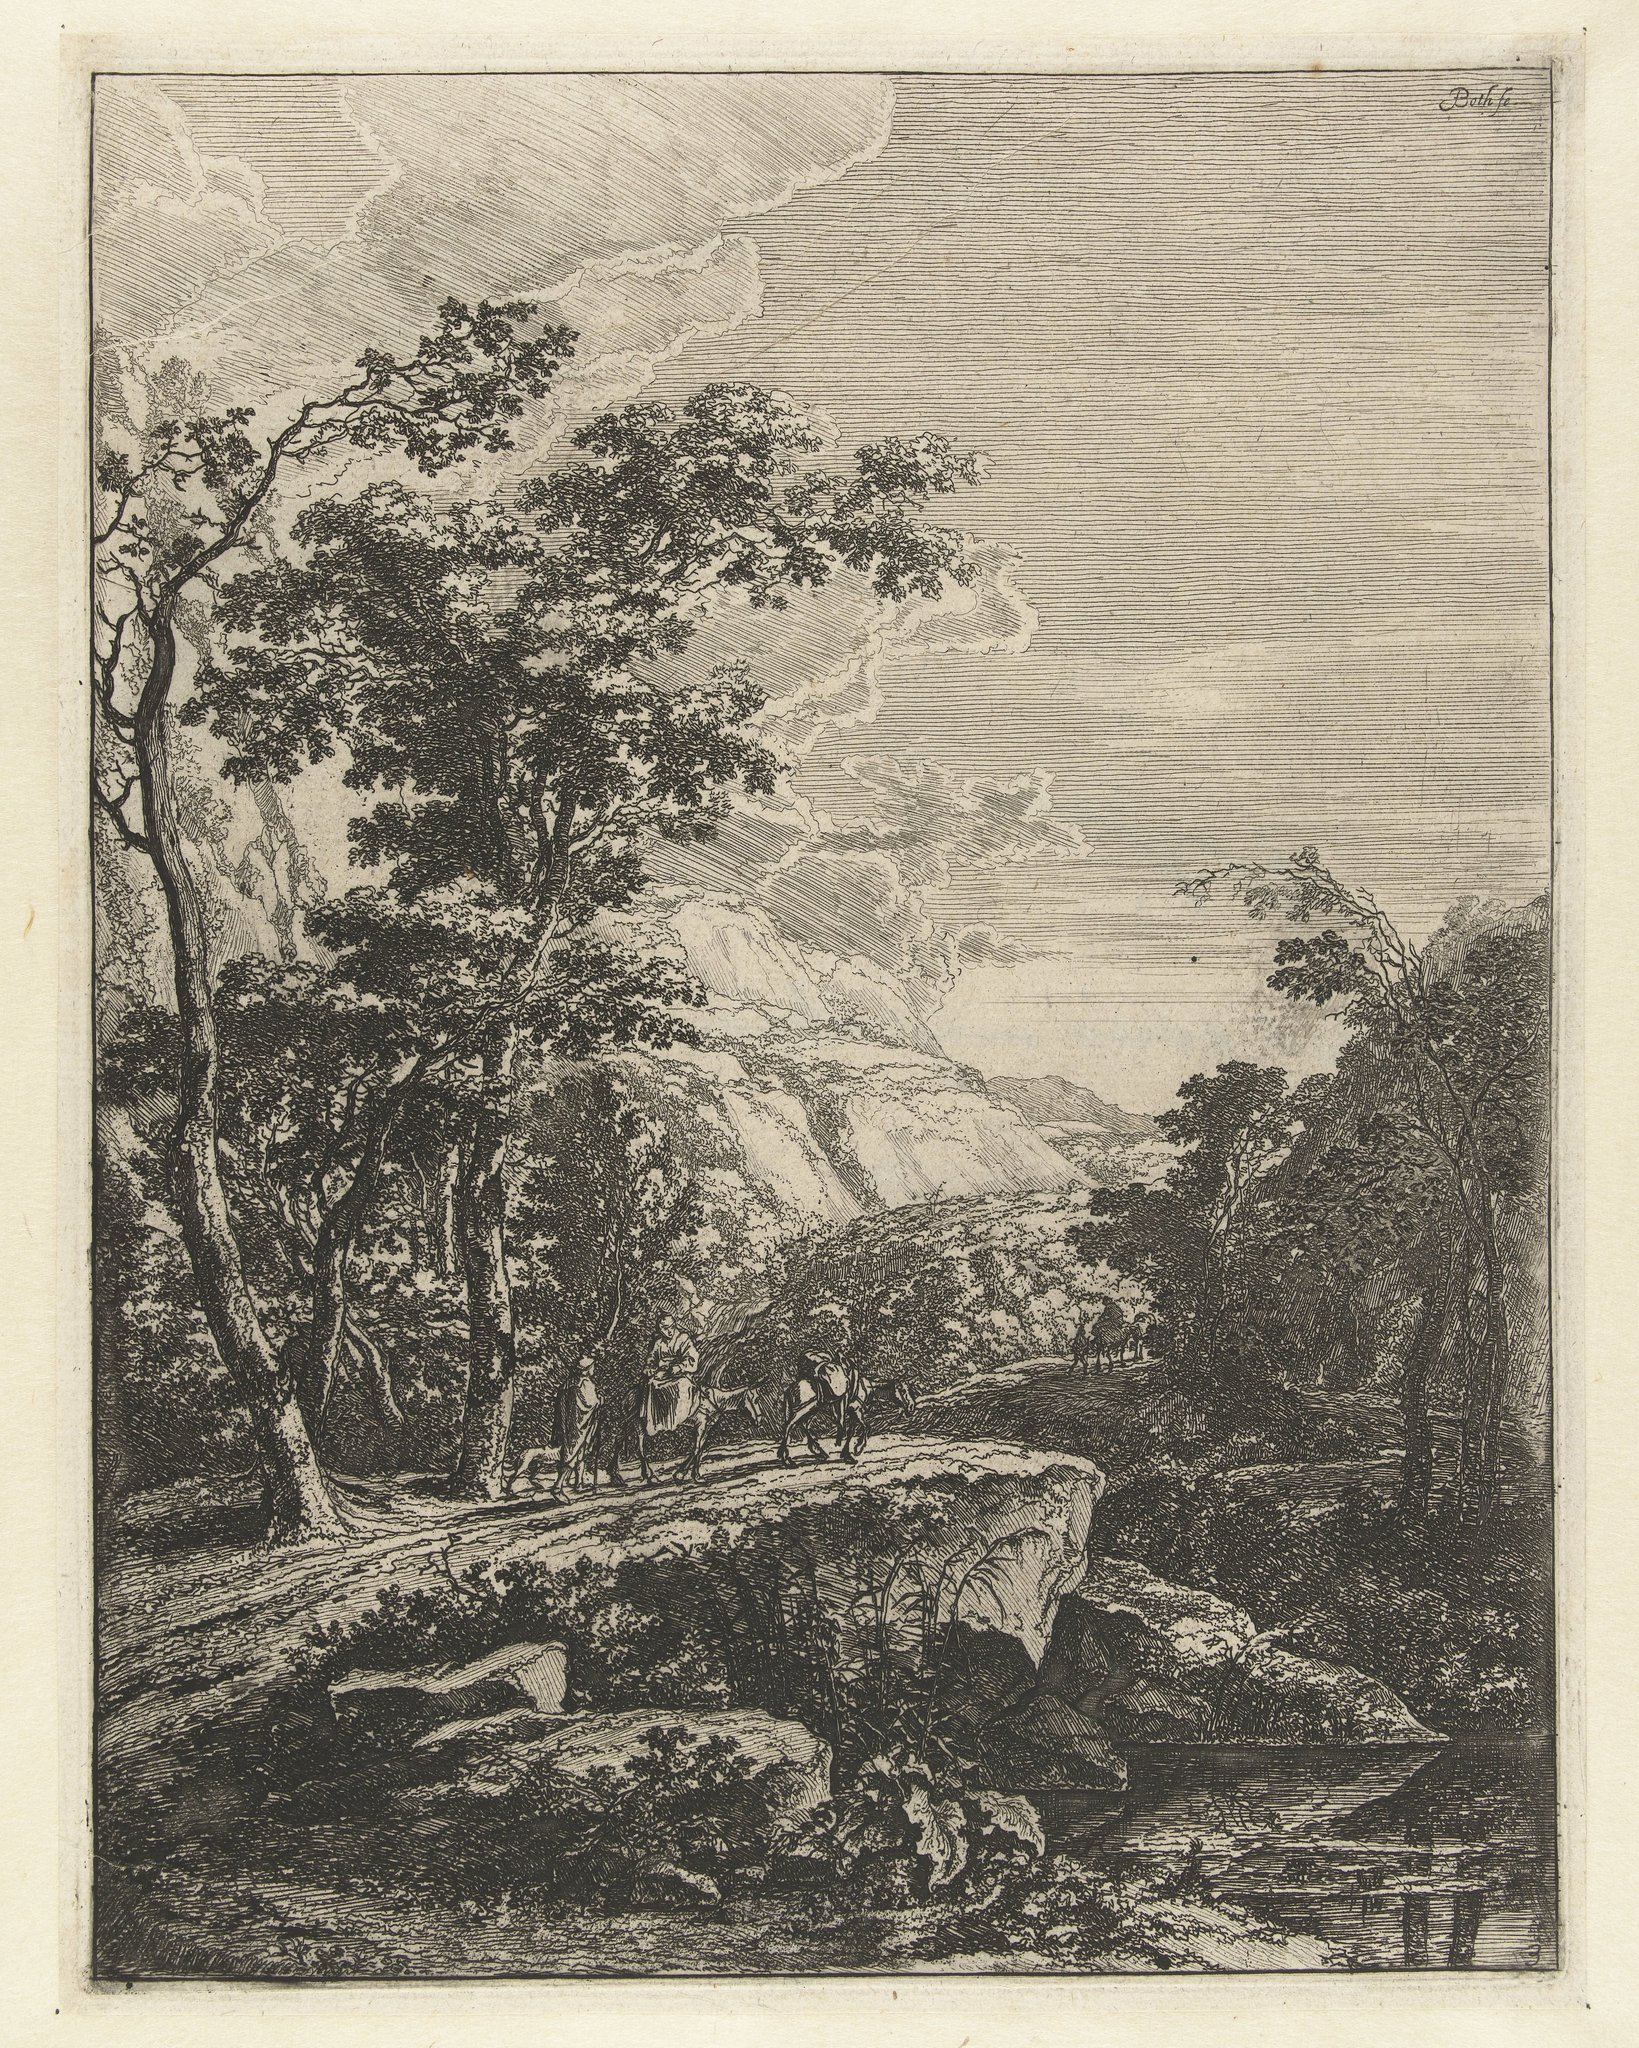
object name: print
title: Italiaanse landschappen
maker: jan both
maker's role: draughtsman, painter, print maker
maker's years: 1618-1652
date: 1644-1652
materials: paper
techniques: etching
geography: utrecht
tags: mule, rocks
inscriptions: collector's mark: Lugt 2228a